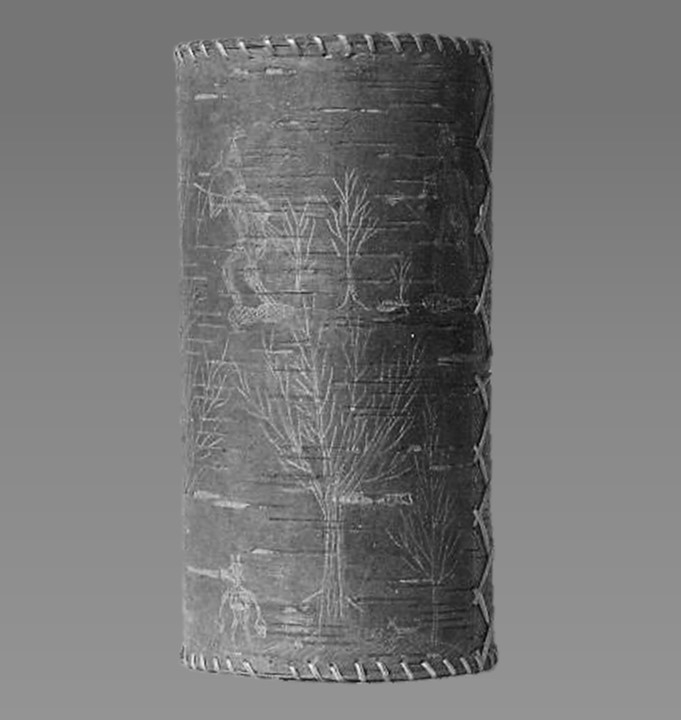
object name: drum or containter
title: Drum or Container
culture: native american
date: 1867-1900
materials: wood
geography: canada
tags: men,trees